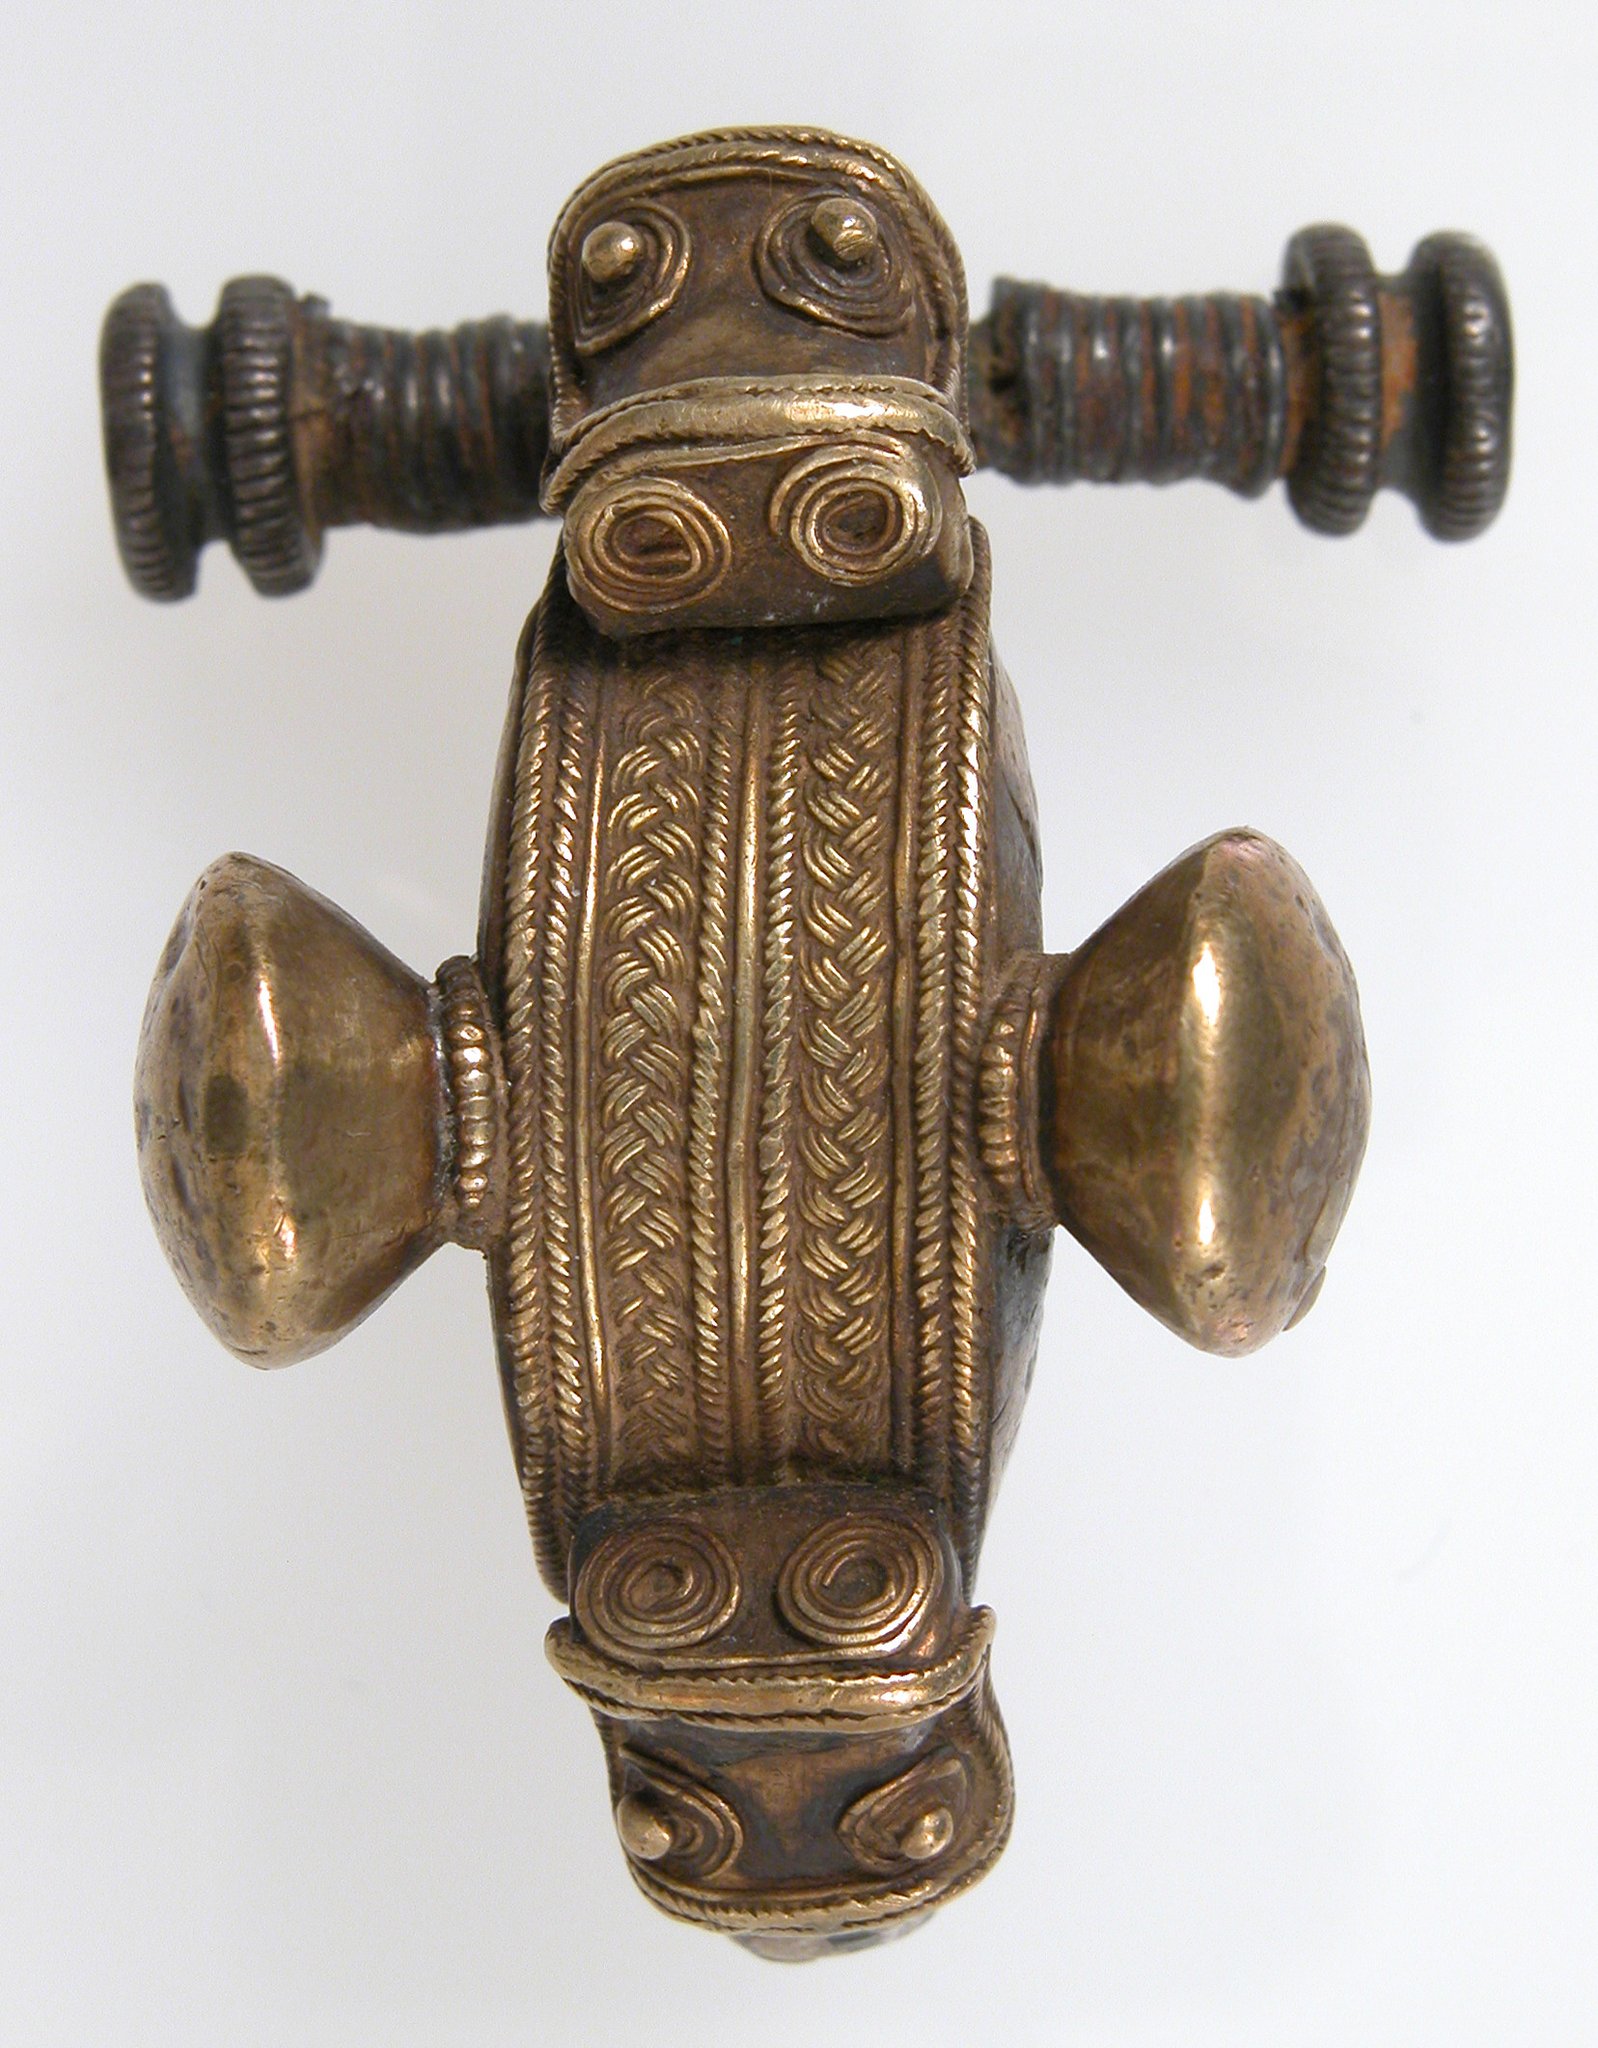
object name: brooch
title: Bow Brooch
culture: baltic or scandinavian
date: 601-700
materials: gold